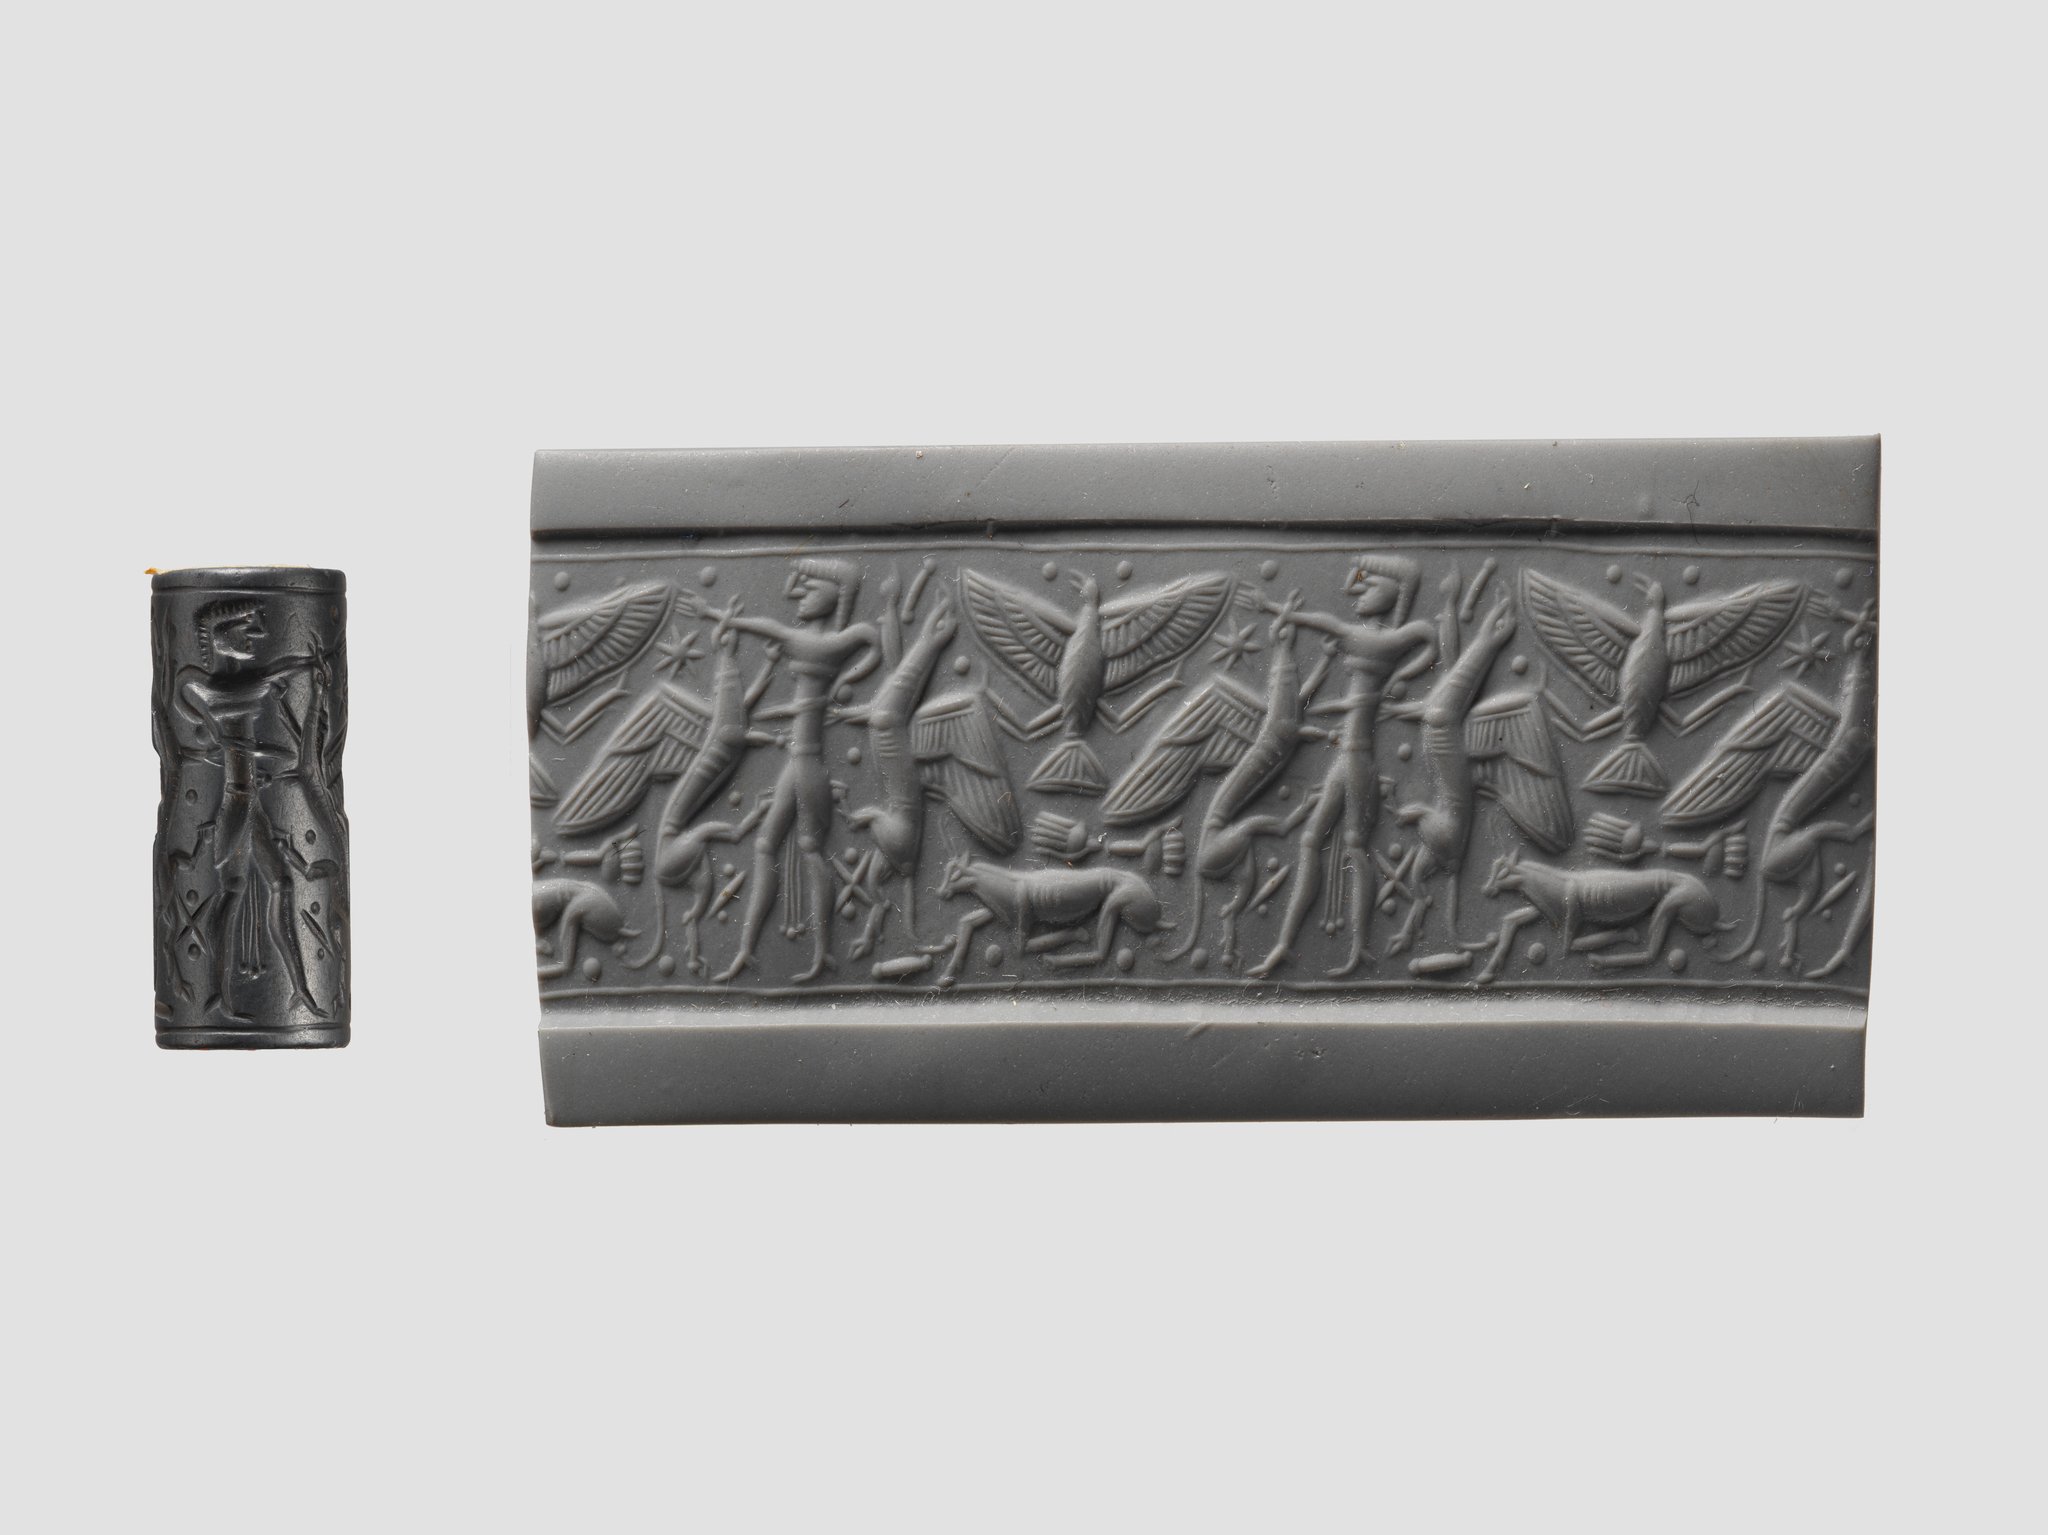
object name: cylinder seal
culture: cypriot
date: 1400-1201 BCE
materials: mineral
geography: cyprus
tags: birds